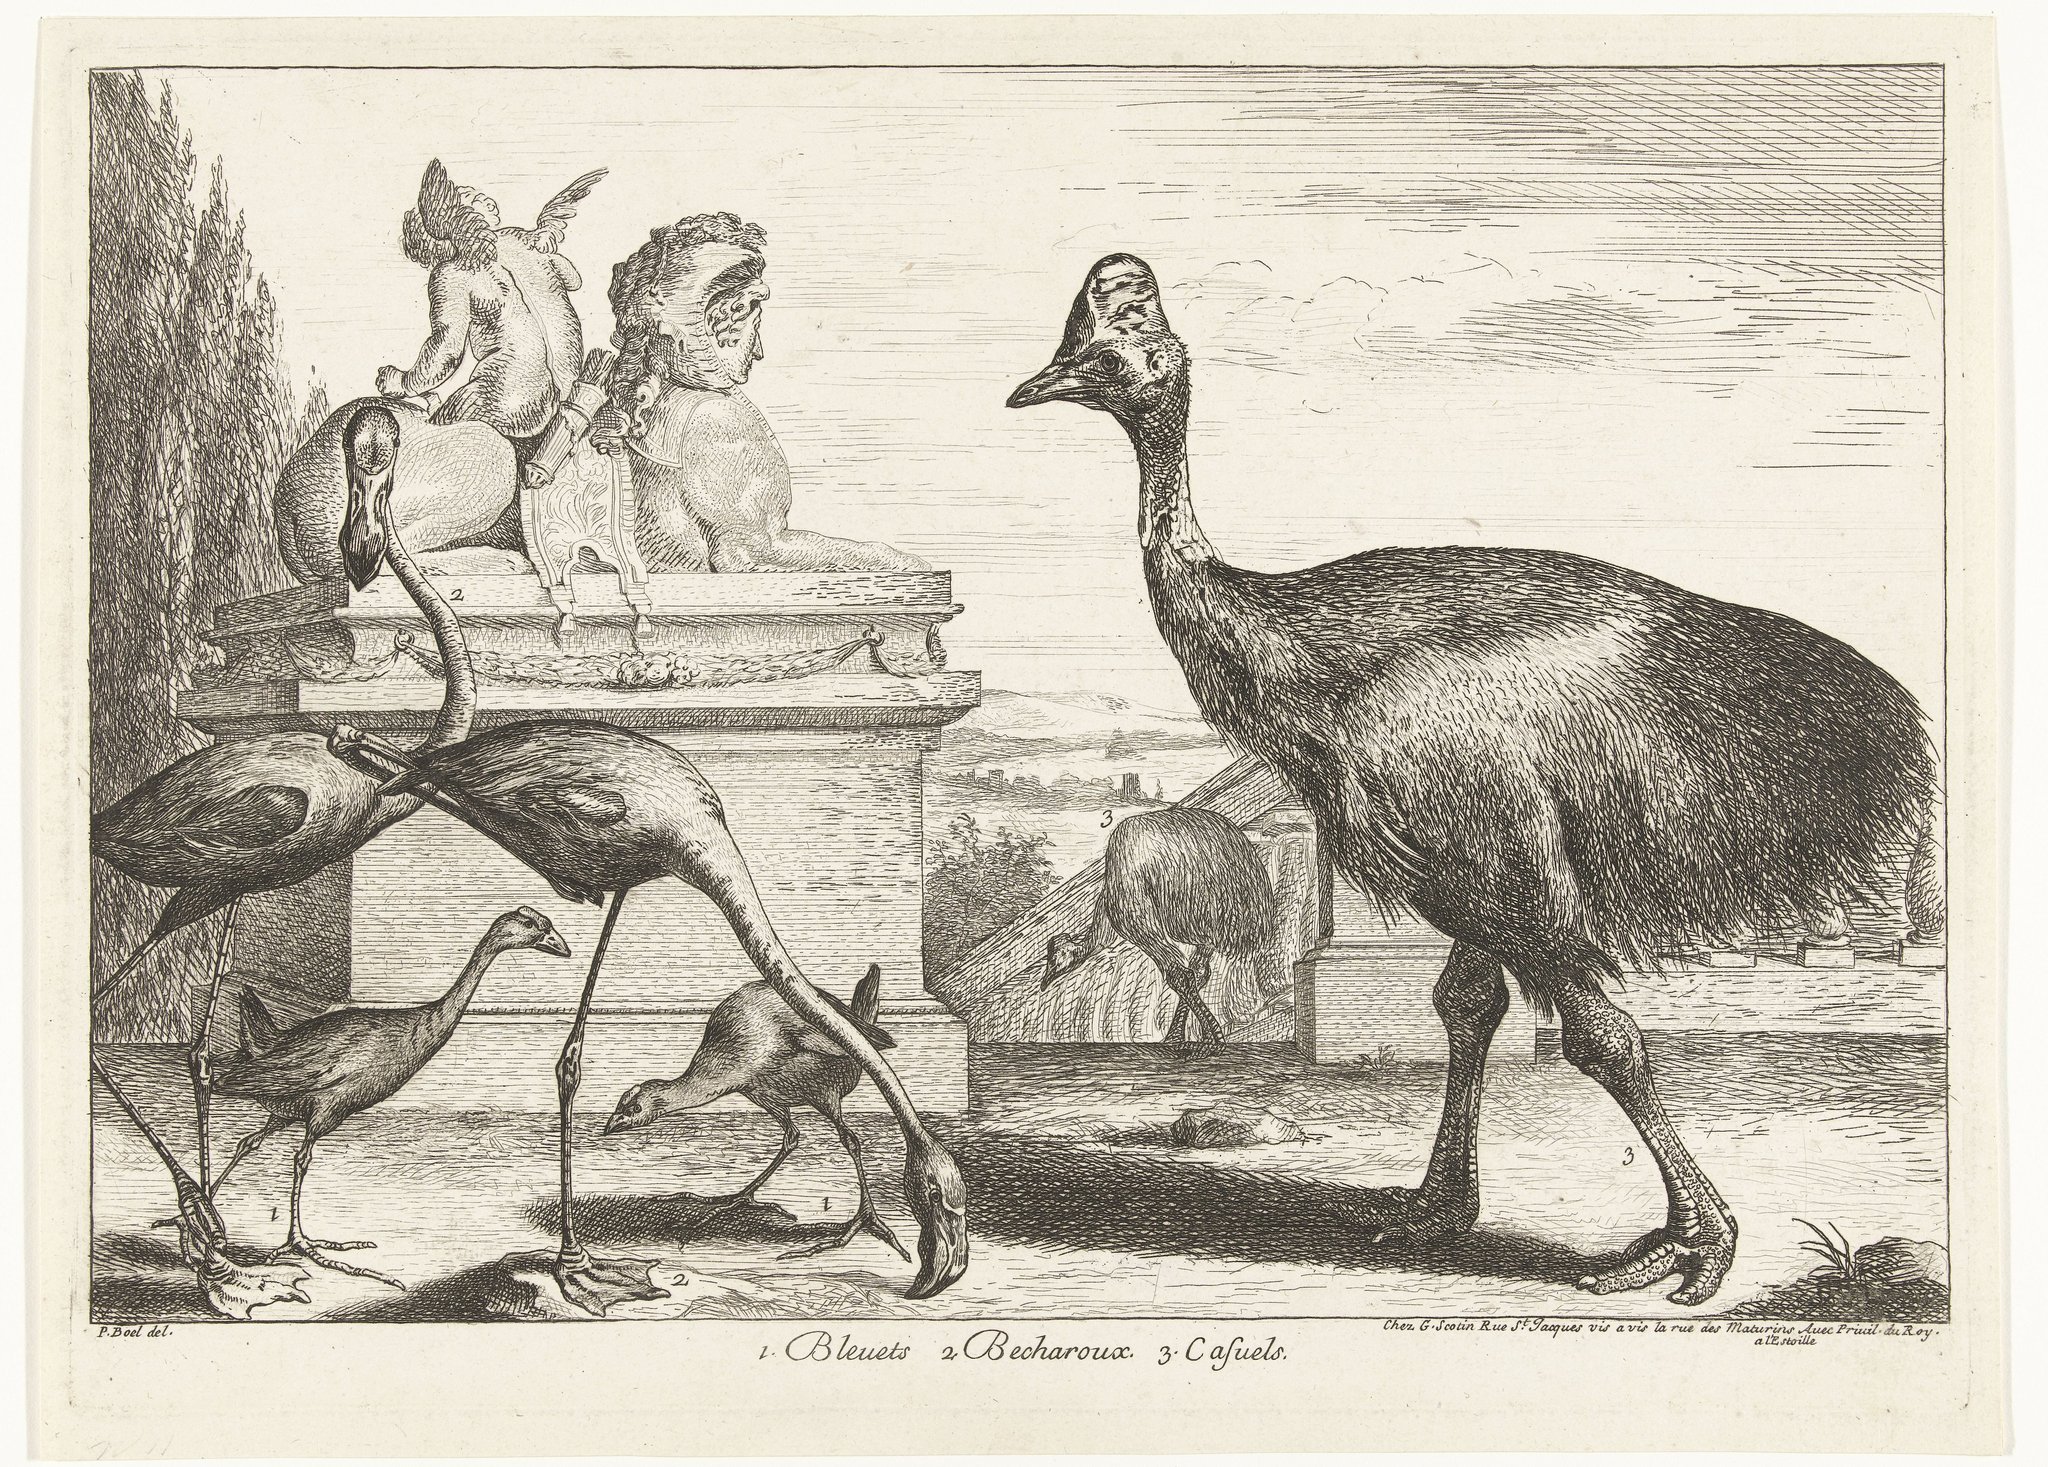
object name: print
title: Kasuarissen, purperkoet en flamingo's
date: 1670-1674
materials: paper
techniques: etching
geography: paris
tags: birds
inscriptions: collector's mark: Lugt 2228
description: Exotische vogels in de tuinen van Versailles. Voor een beeld van een sfinx lopen kasuarissen, purperkoeten en flamingo's.